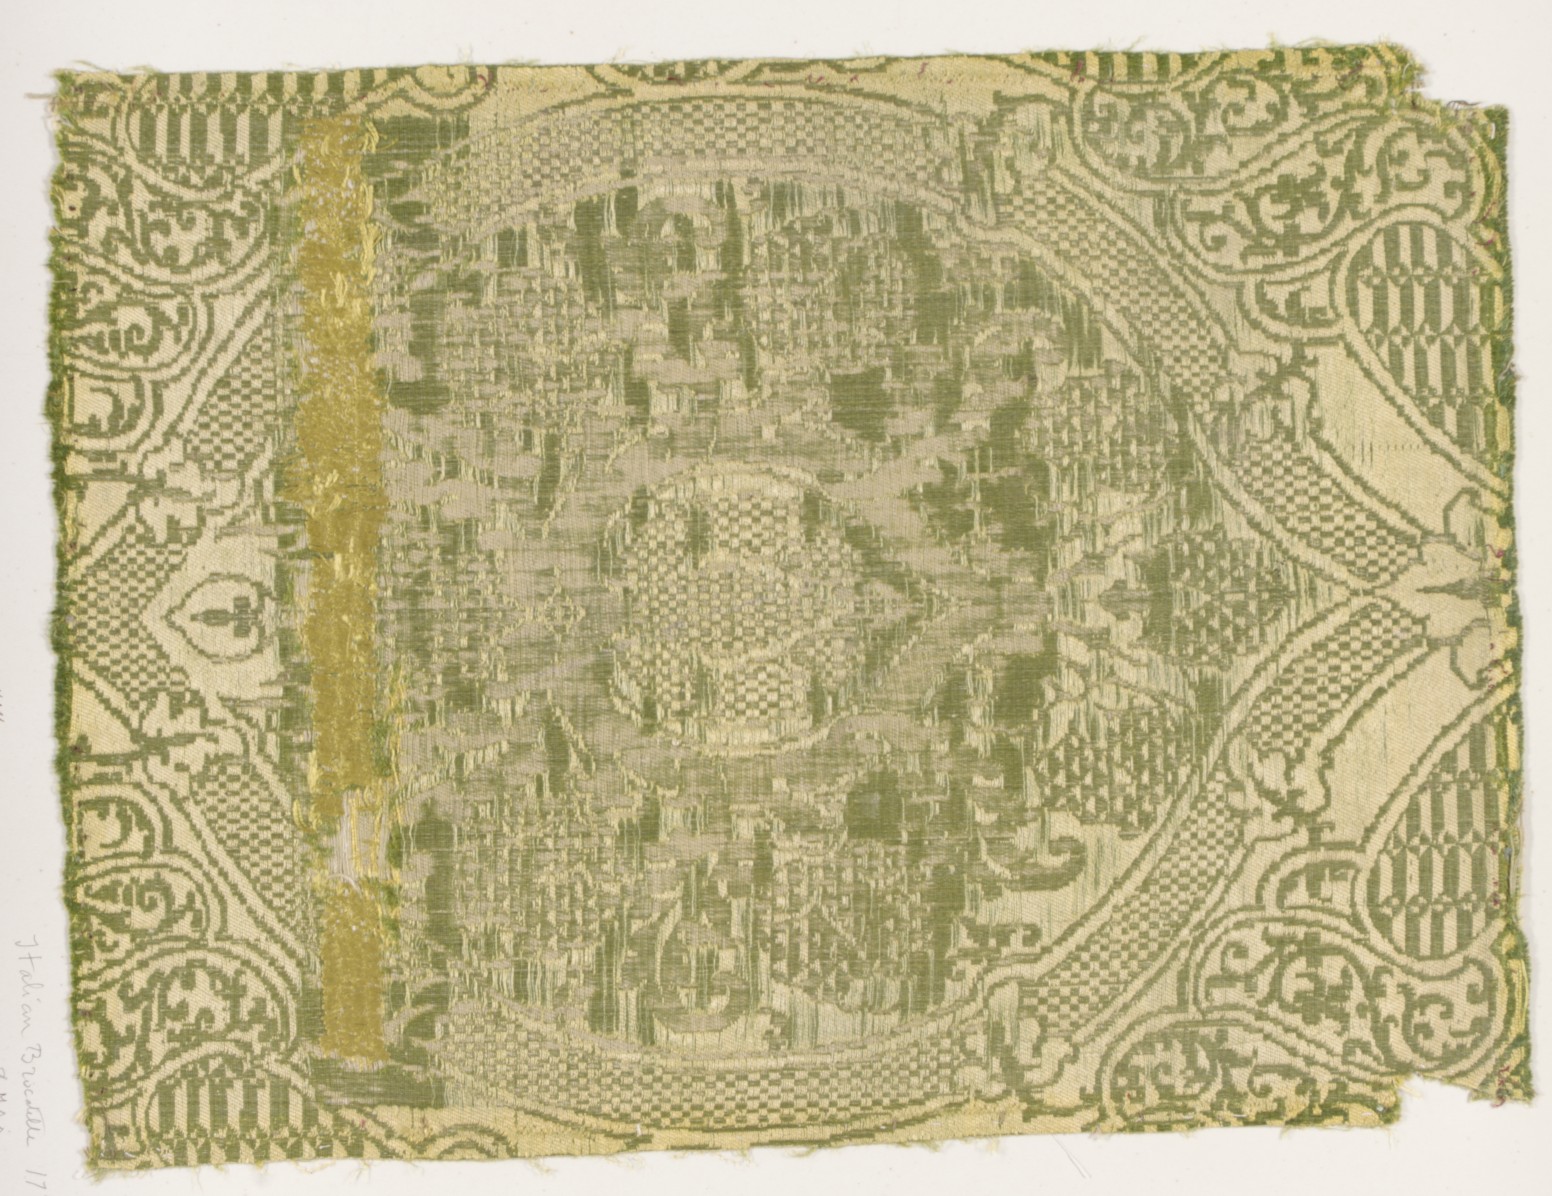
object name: fragment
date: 1601-1700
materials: silk